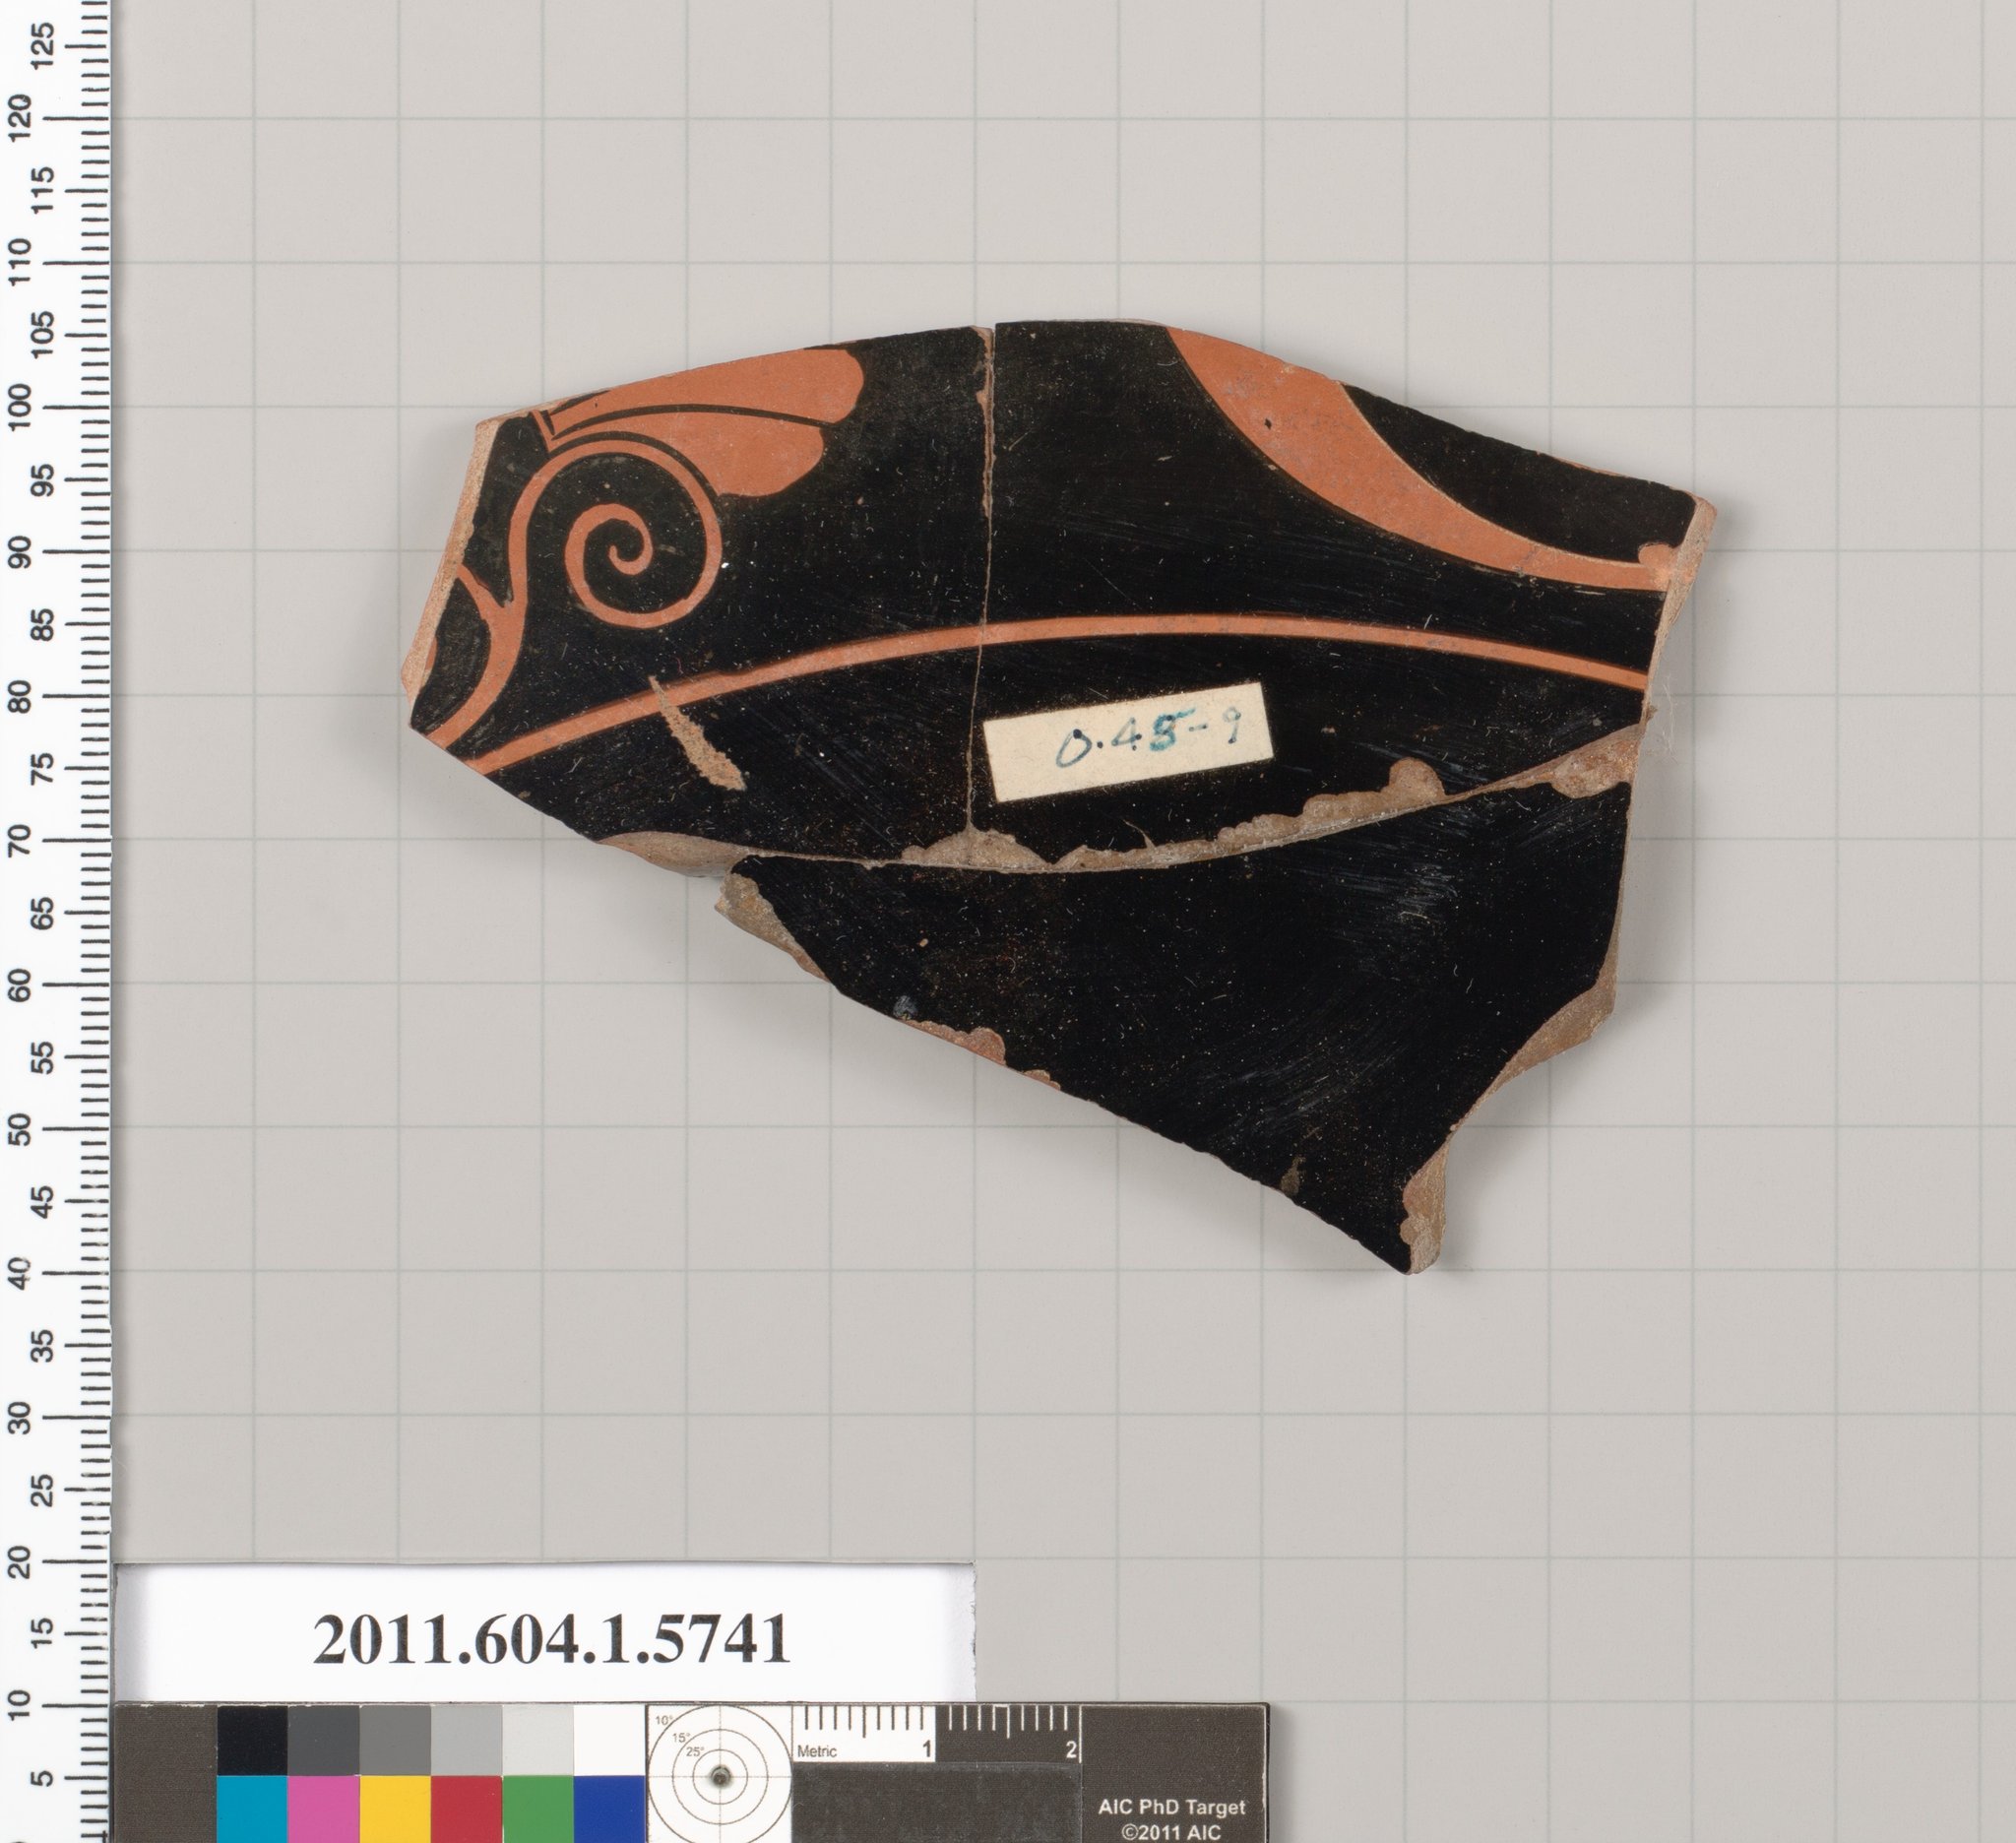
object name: kylix fragment, eye cup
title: Terracotta fragment of a kylix: eye-cup (drinking cup)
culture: greek, attic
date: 525-510 BCE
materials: terracotta